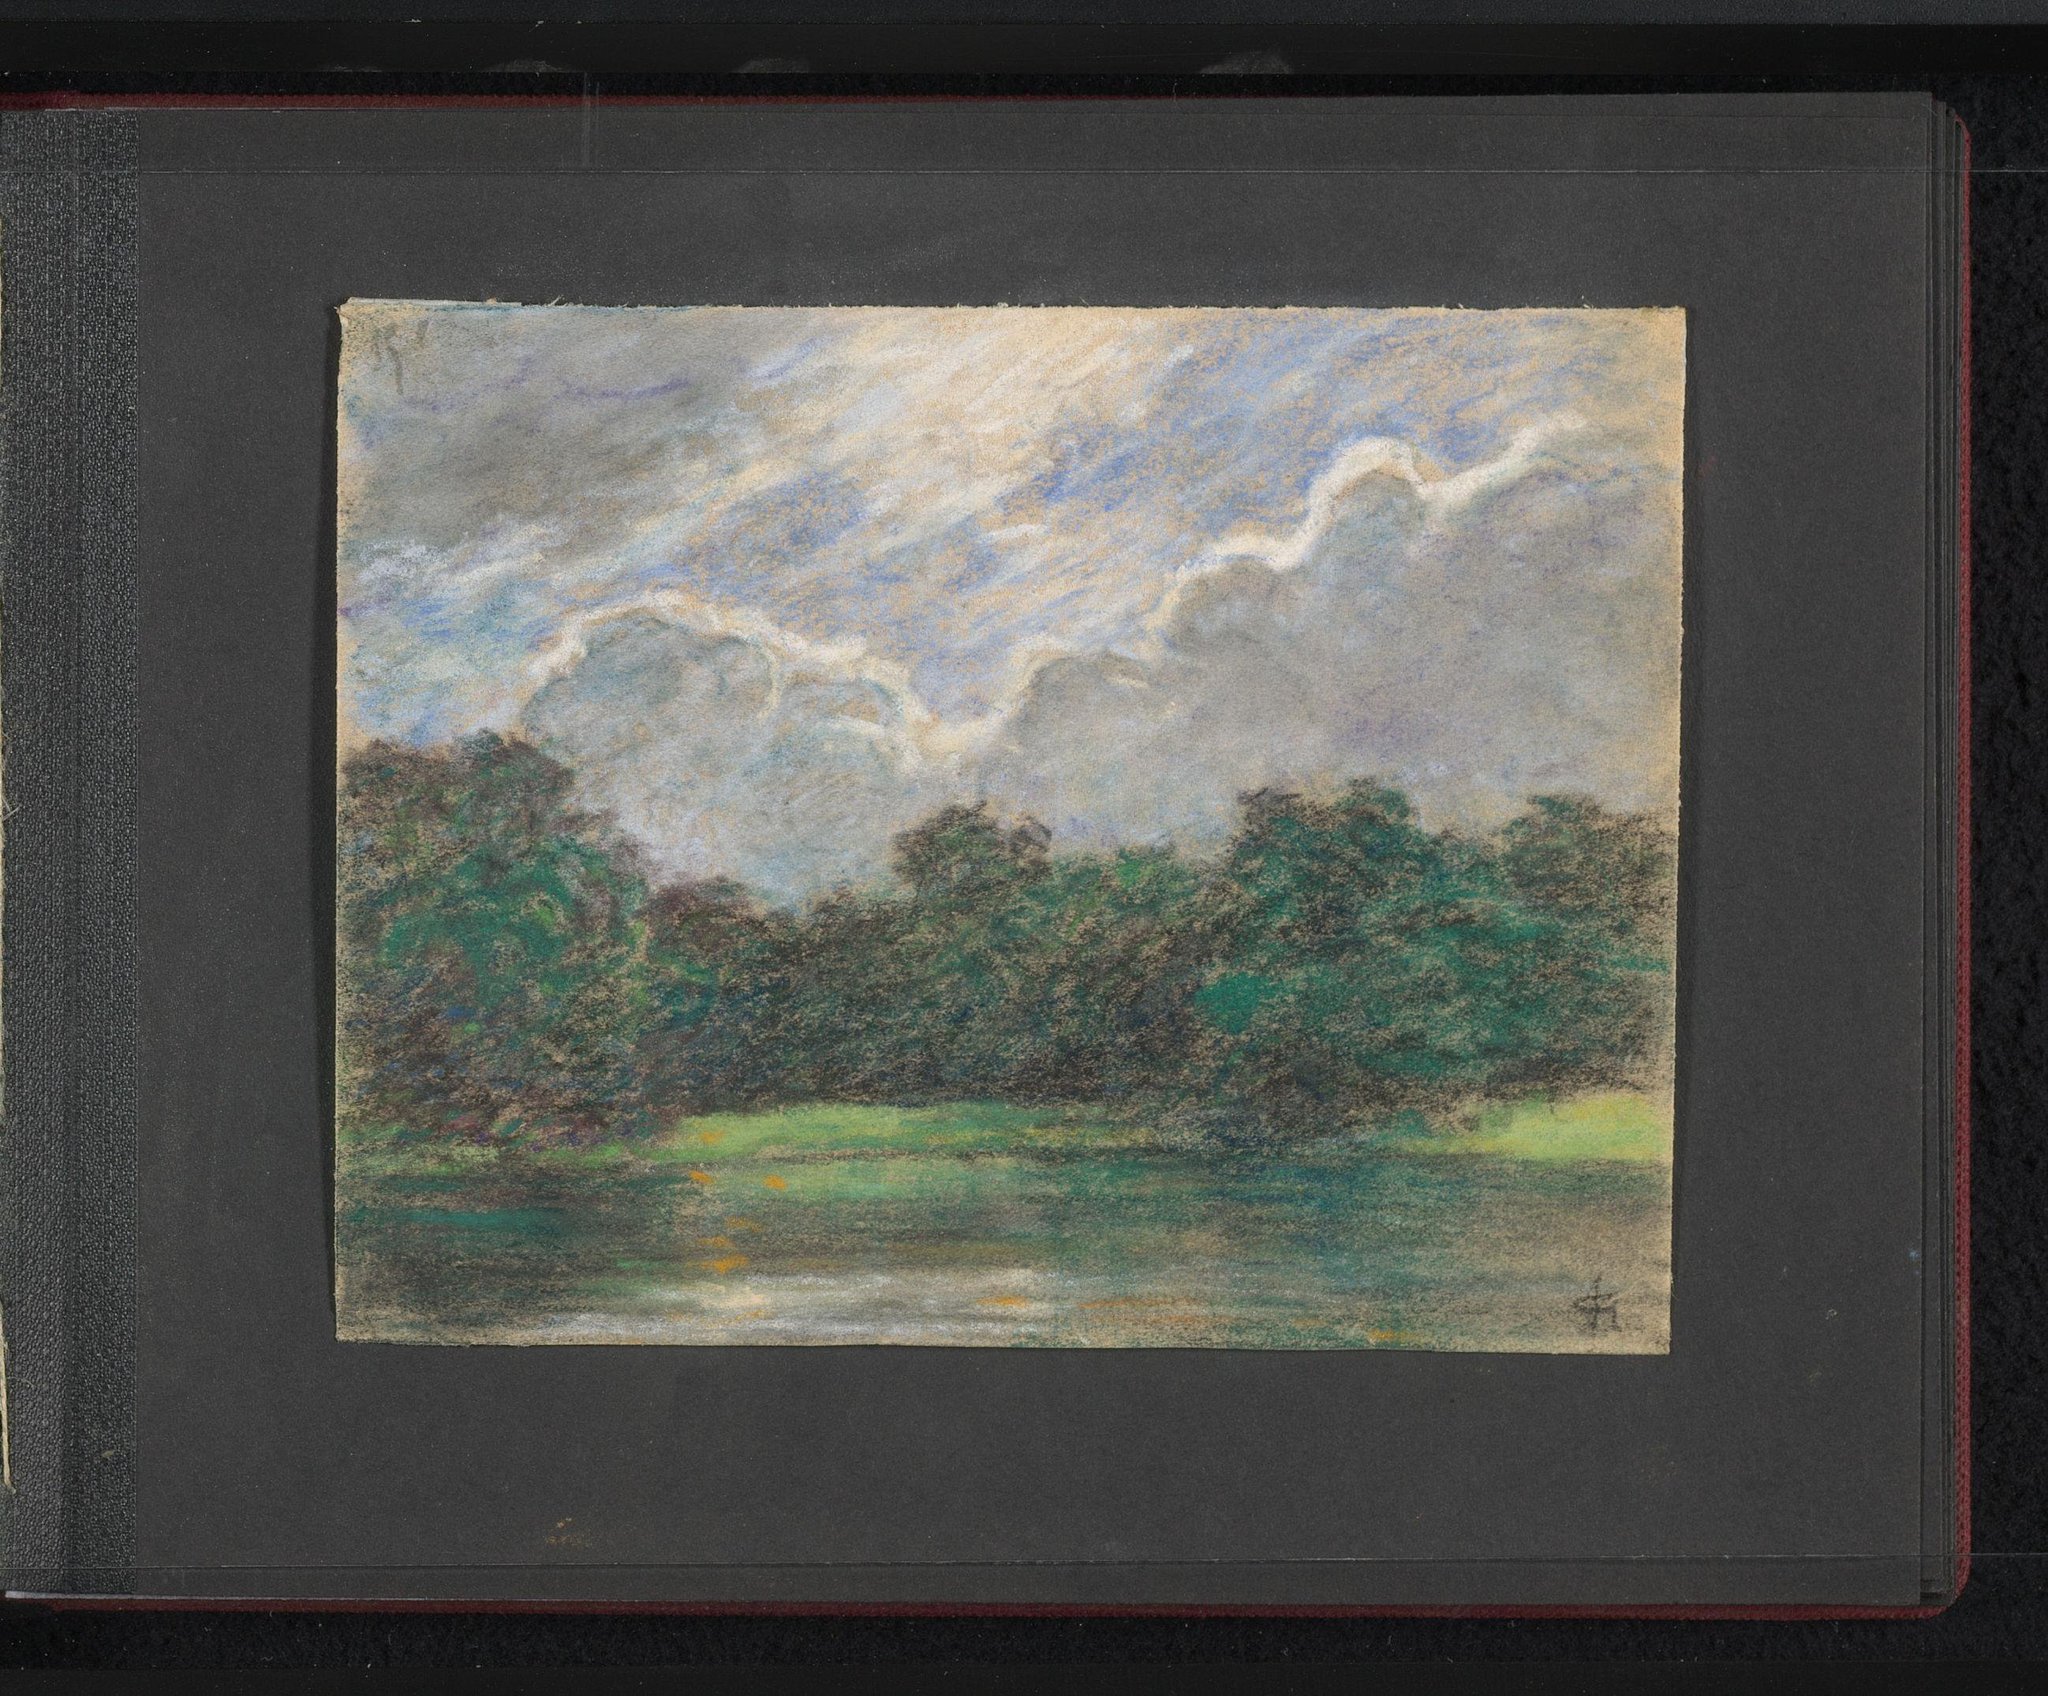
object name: album leaf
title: Bewolkte lucht boven een park met vijver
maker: carel nicolaas storm van s-gravesande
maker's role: draughtsman, print maker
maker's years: 1841-1924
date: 1915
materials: chalk, paper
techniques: pasting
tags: clouds, garden pond, public gardens, park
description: Mogelijk in het Kurpark te Wiesbaden. Tekening maakt deel uit van een album.